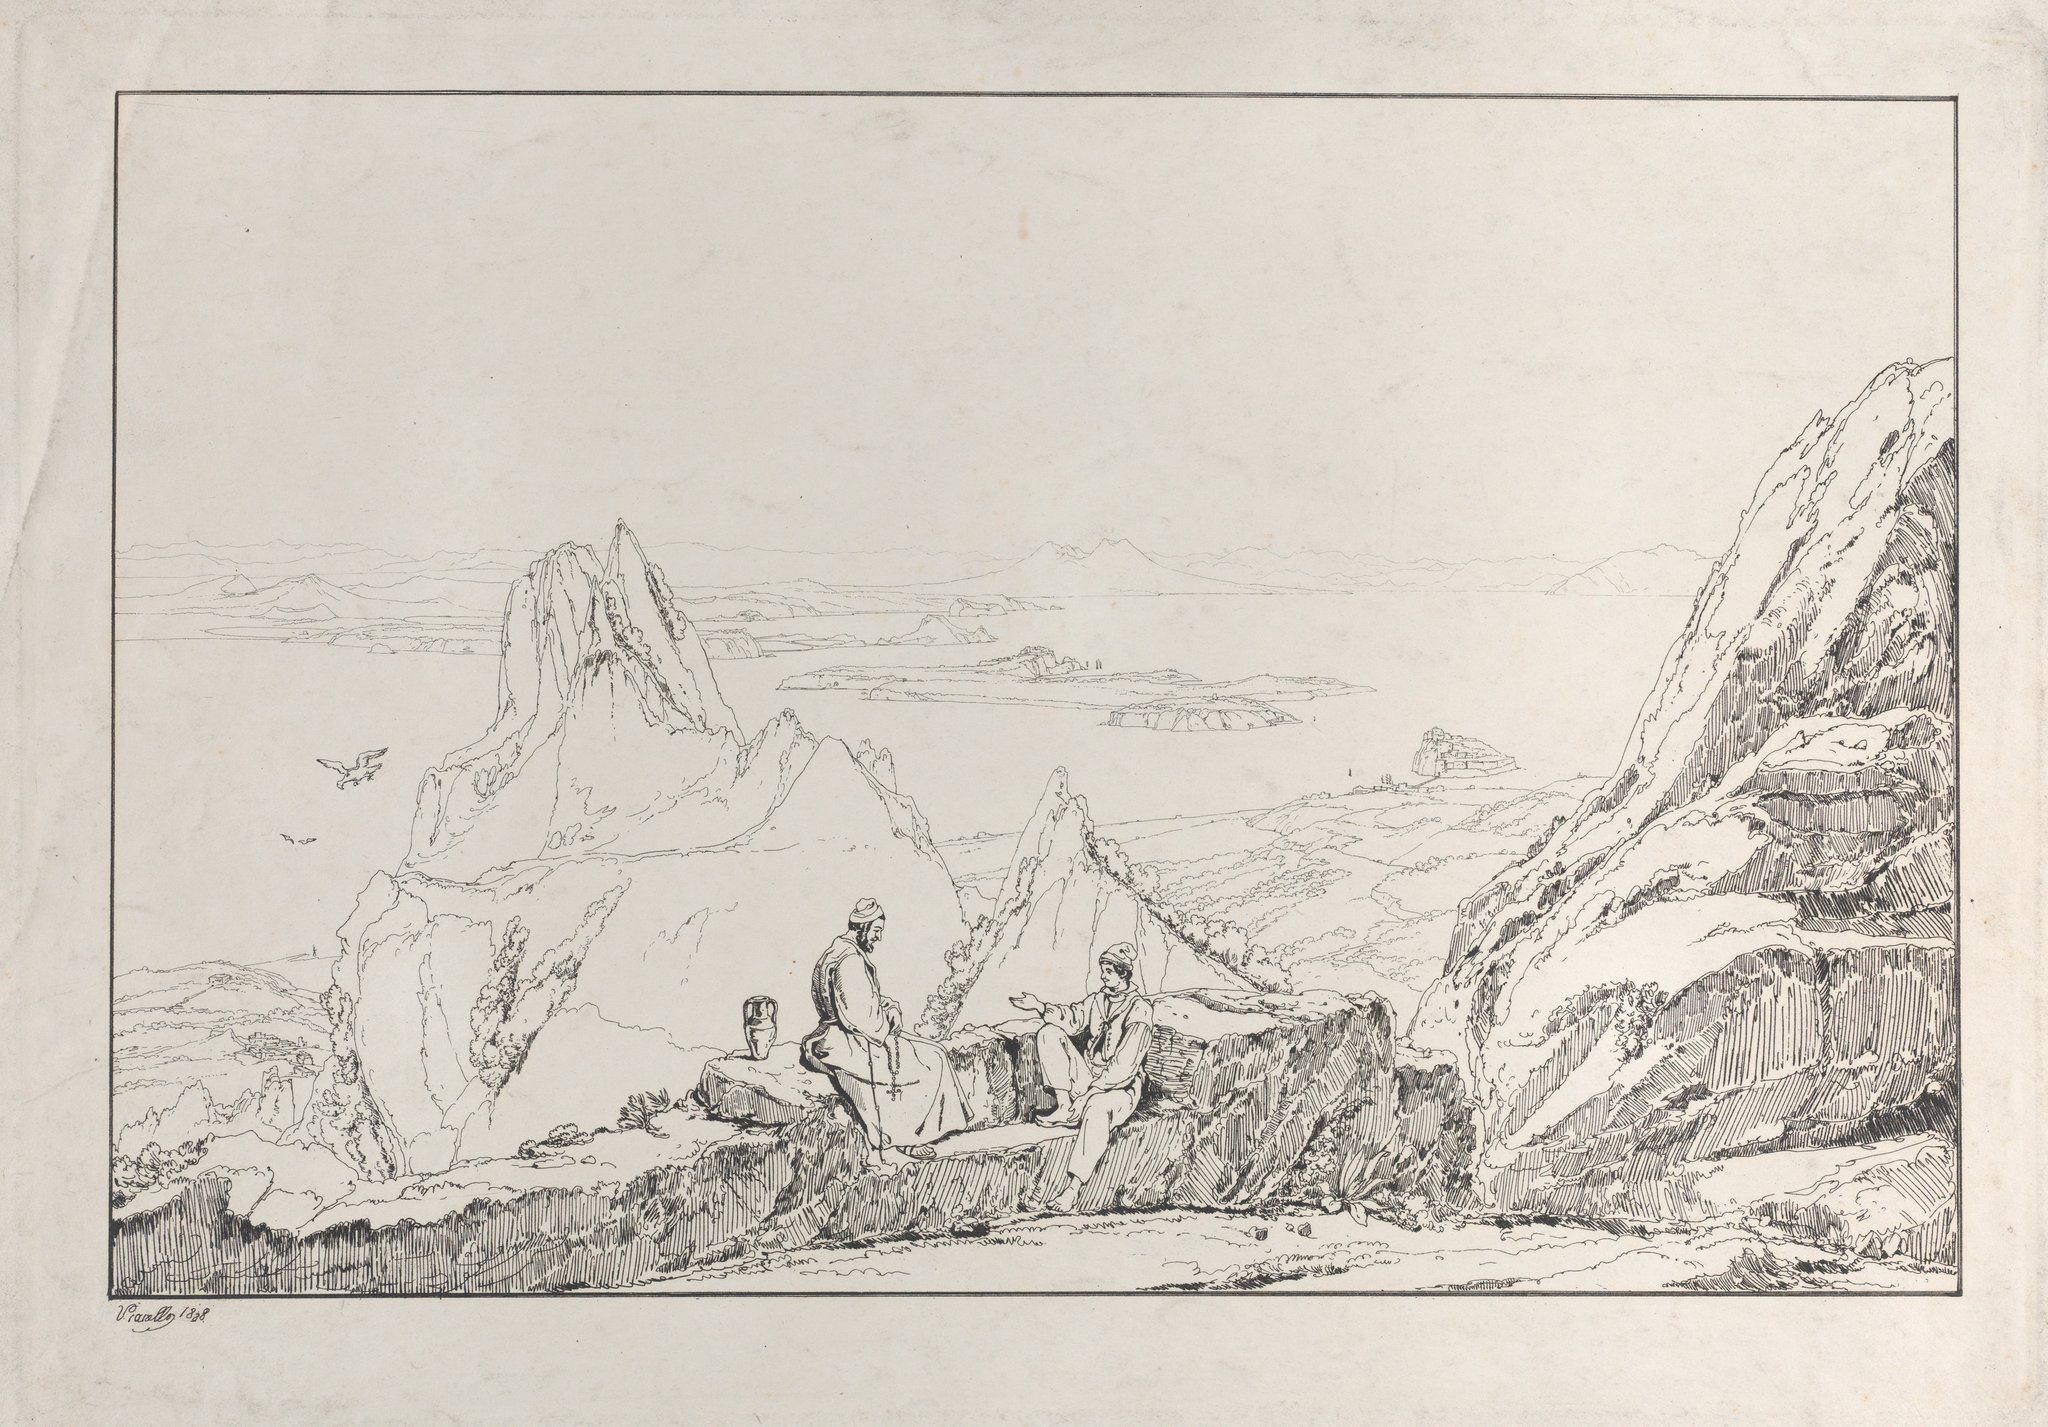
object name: print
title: Mountainous landscape with two men in the foreground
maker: antonio vianello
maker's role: artist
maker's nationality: italian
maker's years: 1778-1878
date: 1828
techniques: etching